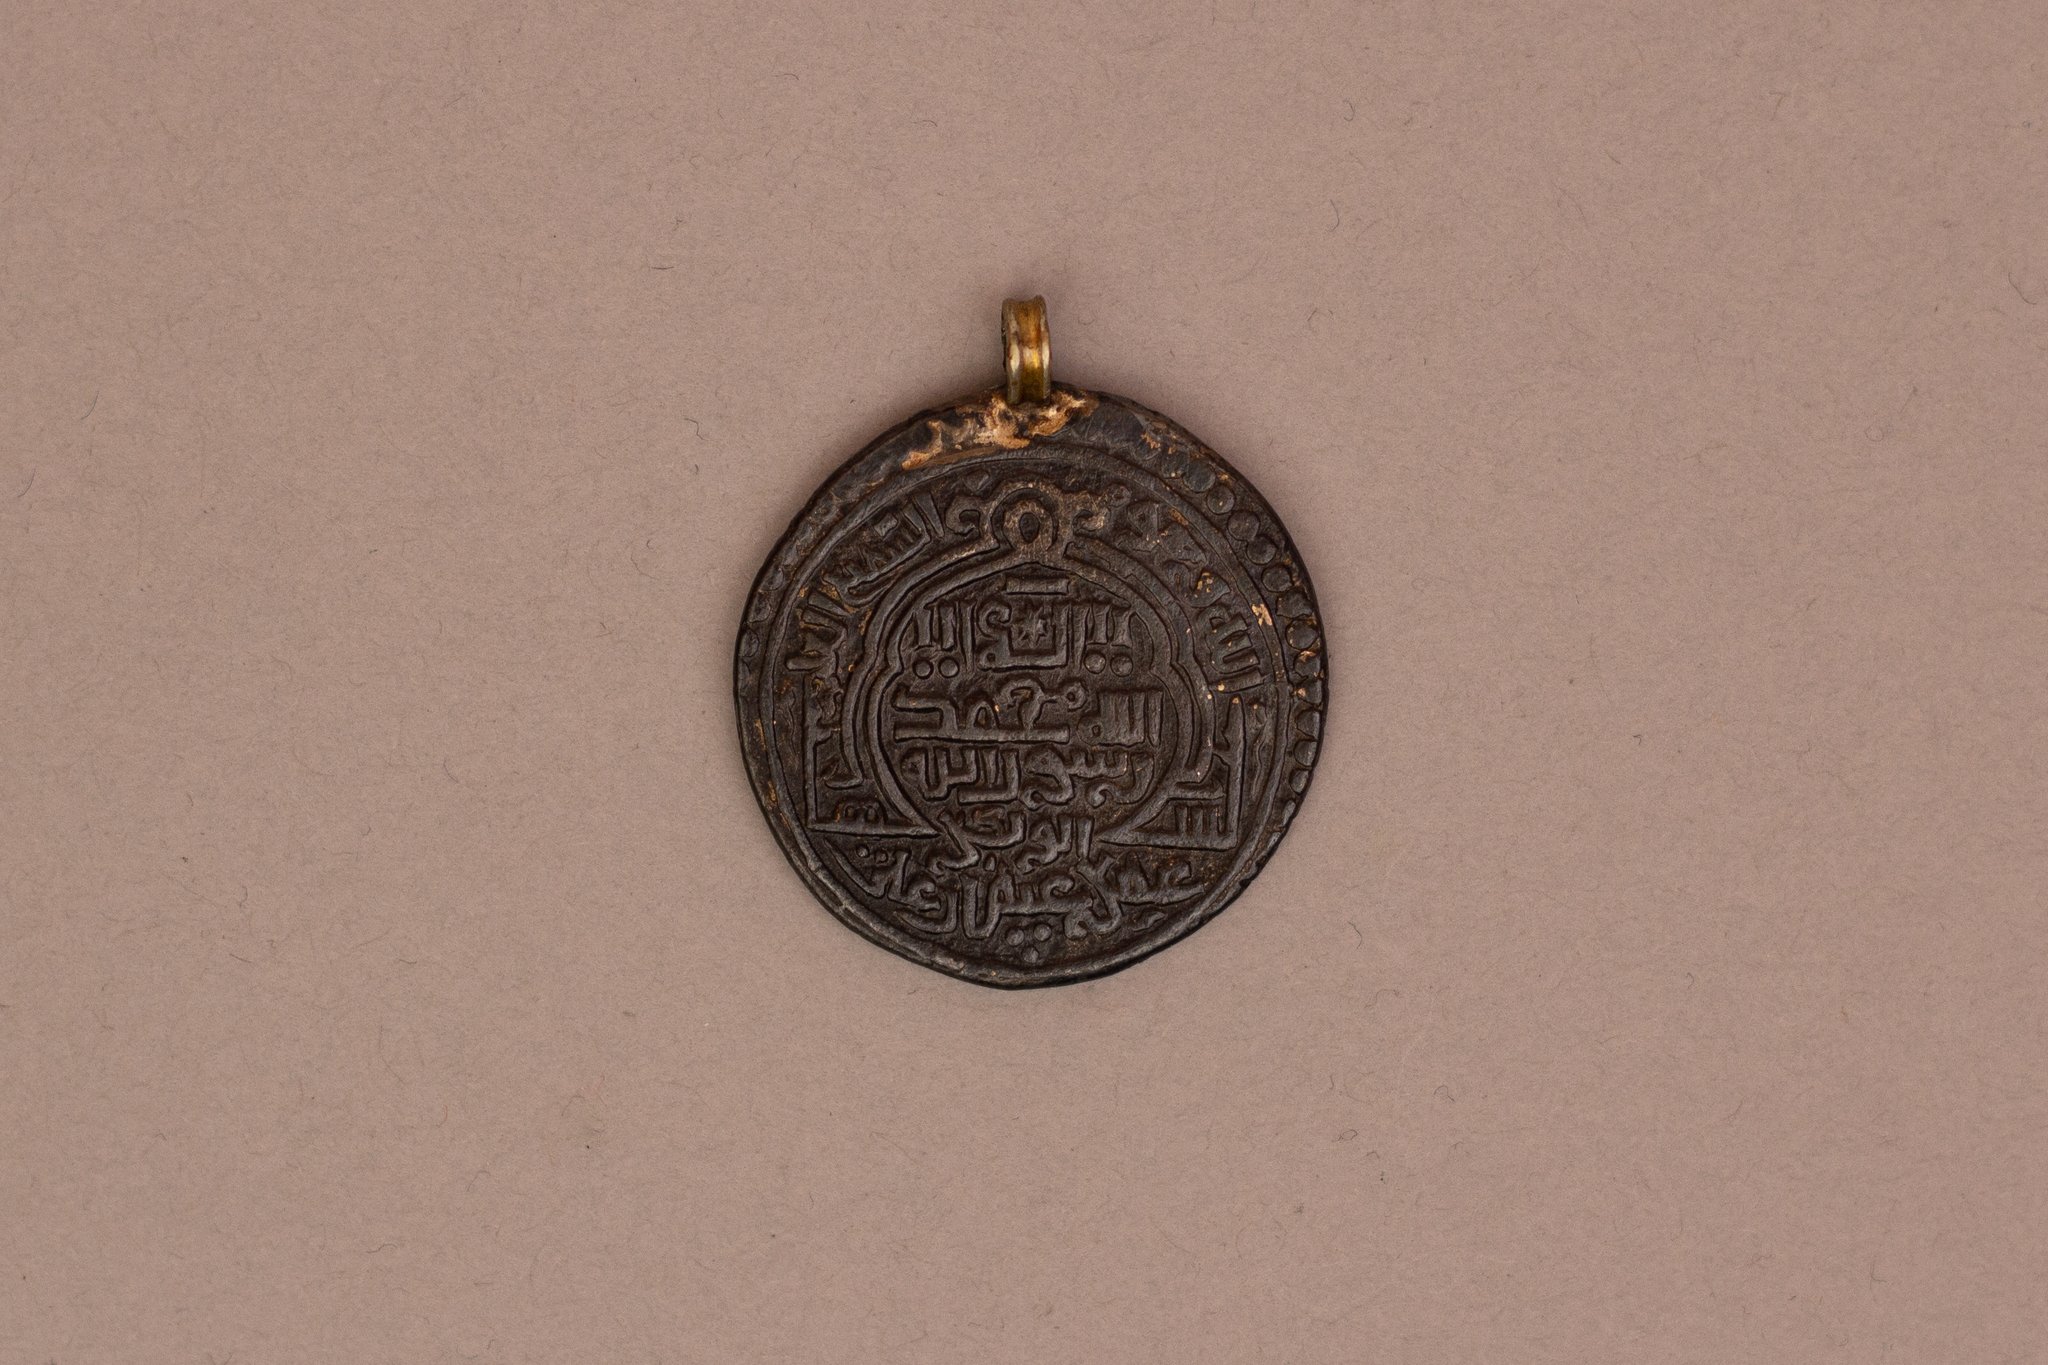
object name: coin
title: Silver coin (dirham) of Abu Sa'id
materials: silver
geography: iran